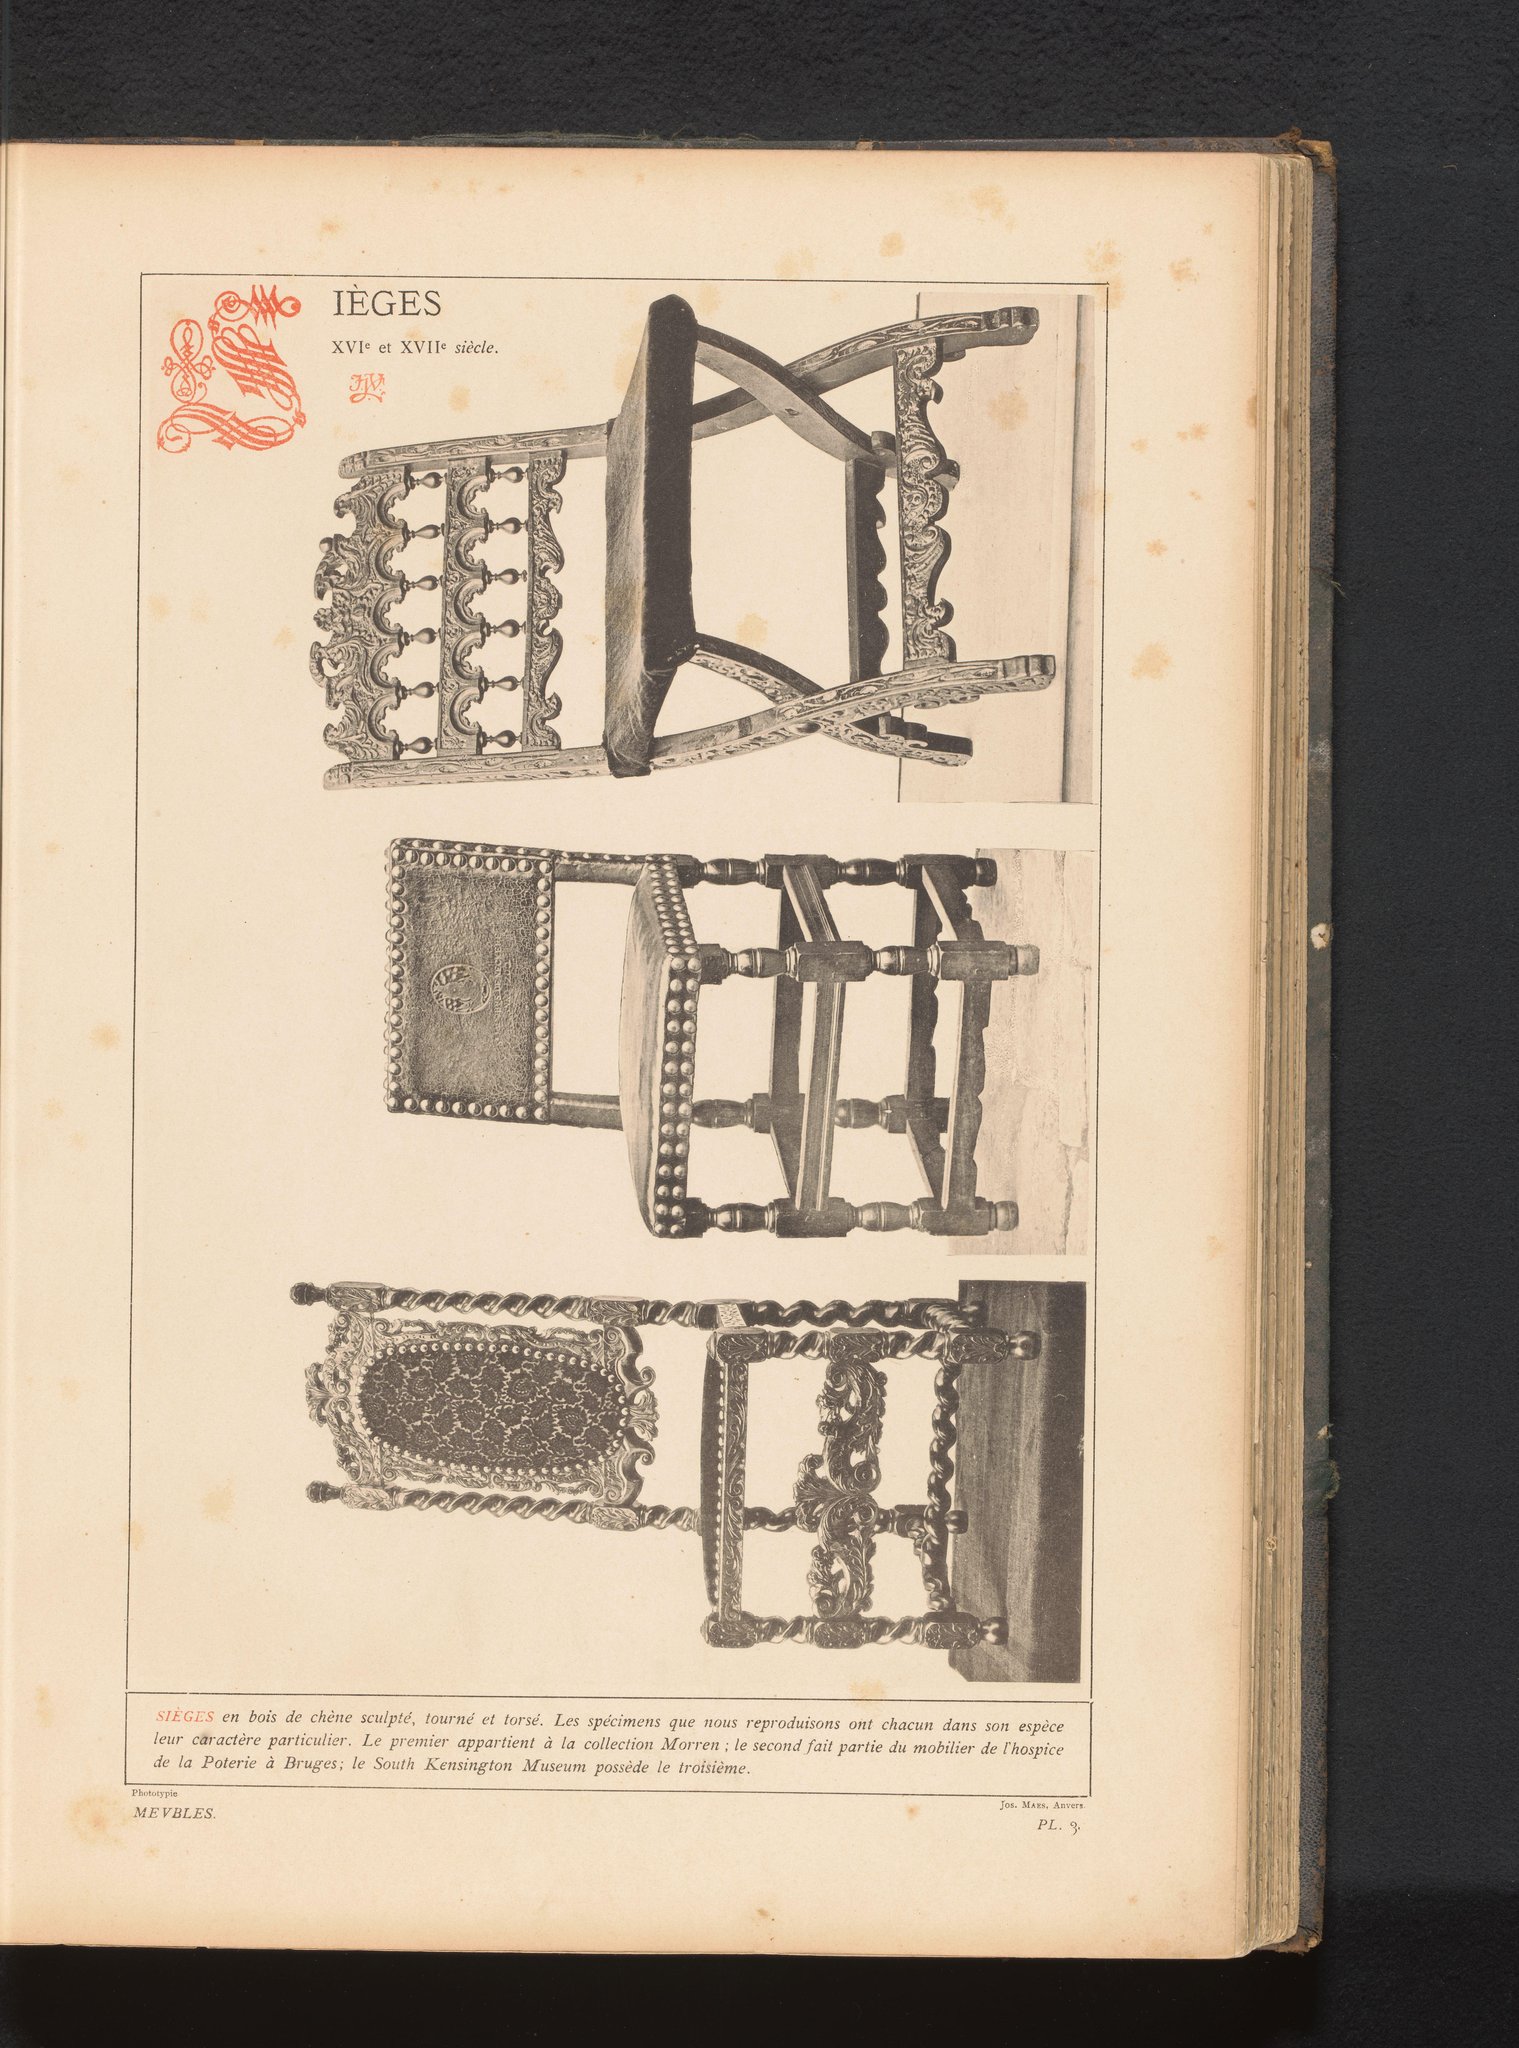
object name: page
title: Drie gedecoreerde stoelen van eikenhout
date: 1882-1887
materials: paper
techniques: photograph, photolithography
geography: antwerp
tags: chair (+ wood and other phytogenic material)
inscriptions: monogram: ‘JJvY’, inscription: ‘SIÈGES en bois (...)’, inscription: ‘MEUBLES. - PL. 3.’